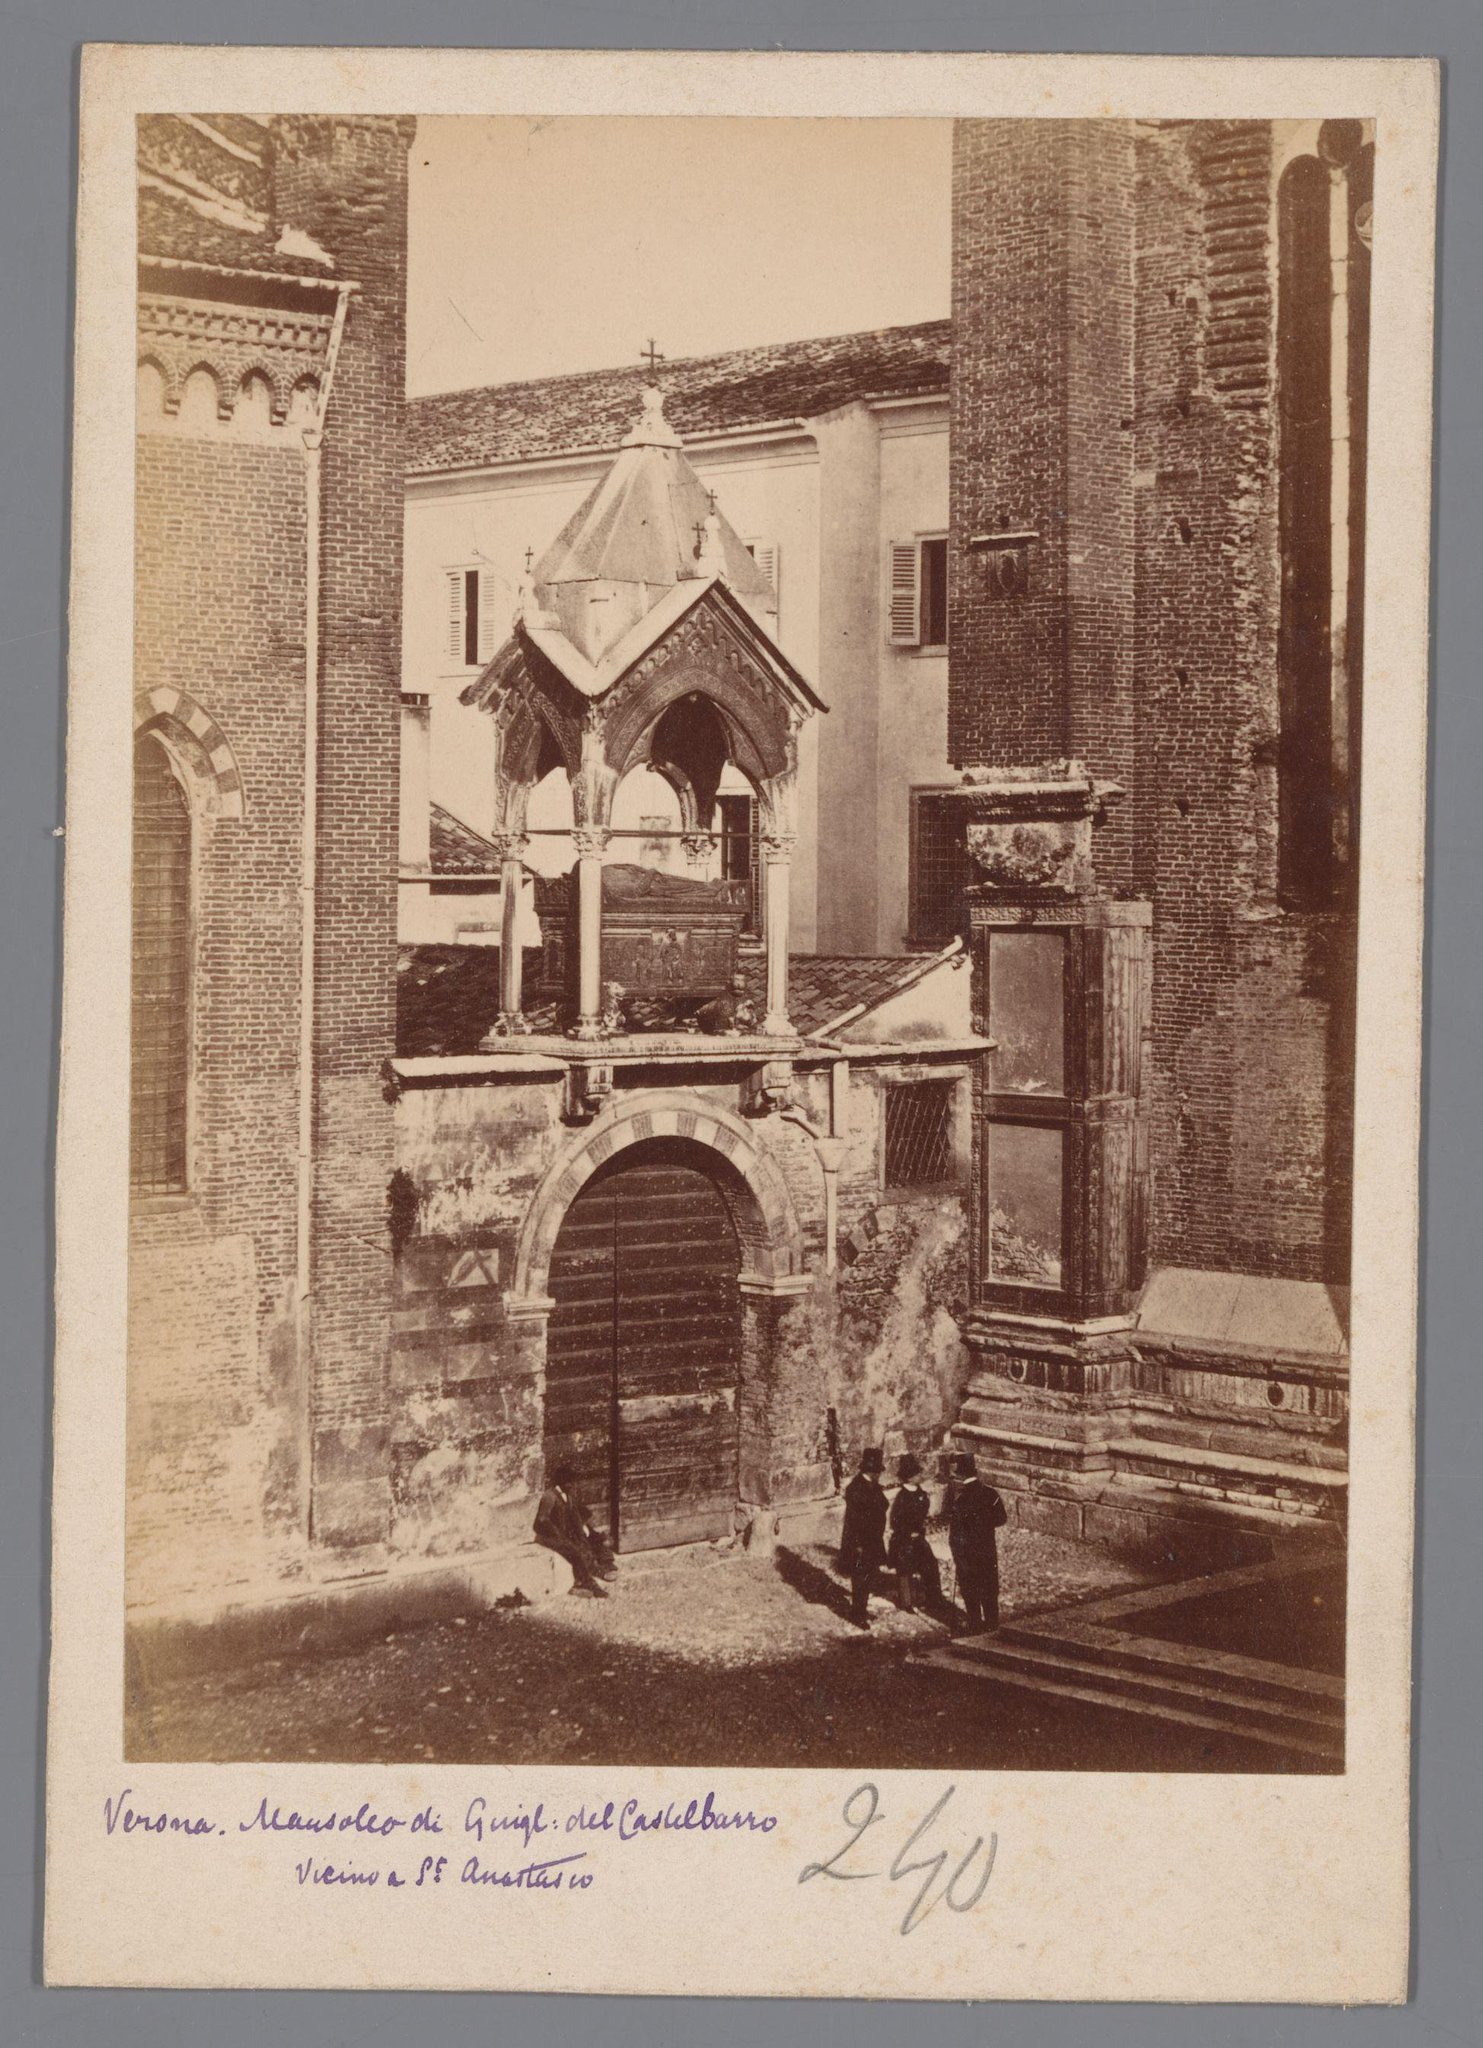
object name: photograph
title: Poort naar de tombe van Guglielmo da Castelbarco in Verona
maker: Anonymous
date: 1851-1900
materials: cardboard, paper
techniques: albumen print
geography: verona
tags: mausoleum, gate, entrance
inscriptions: number: ‘240’